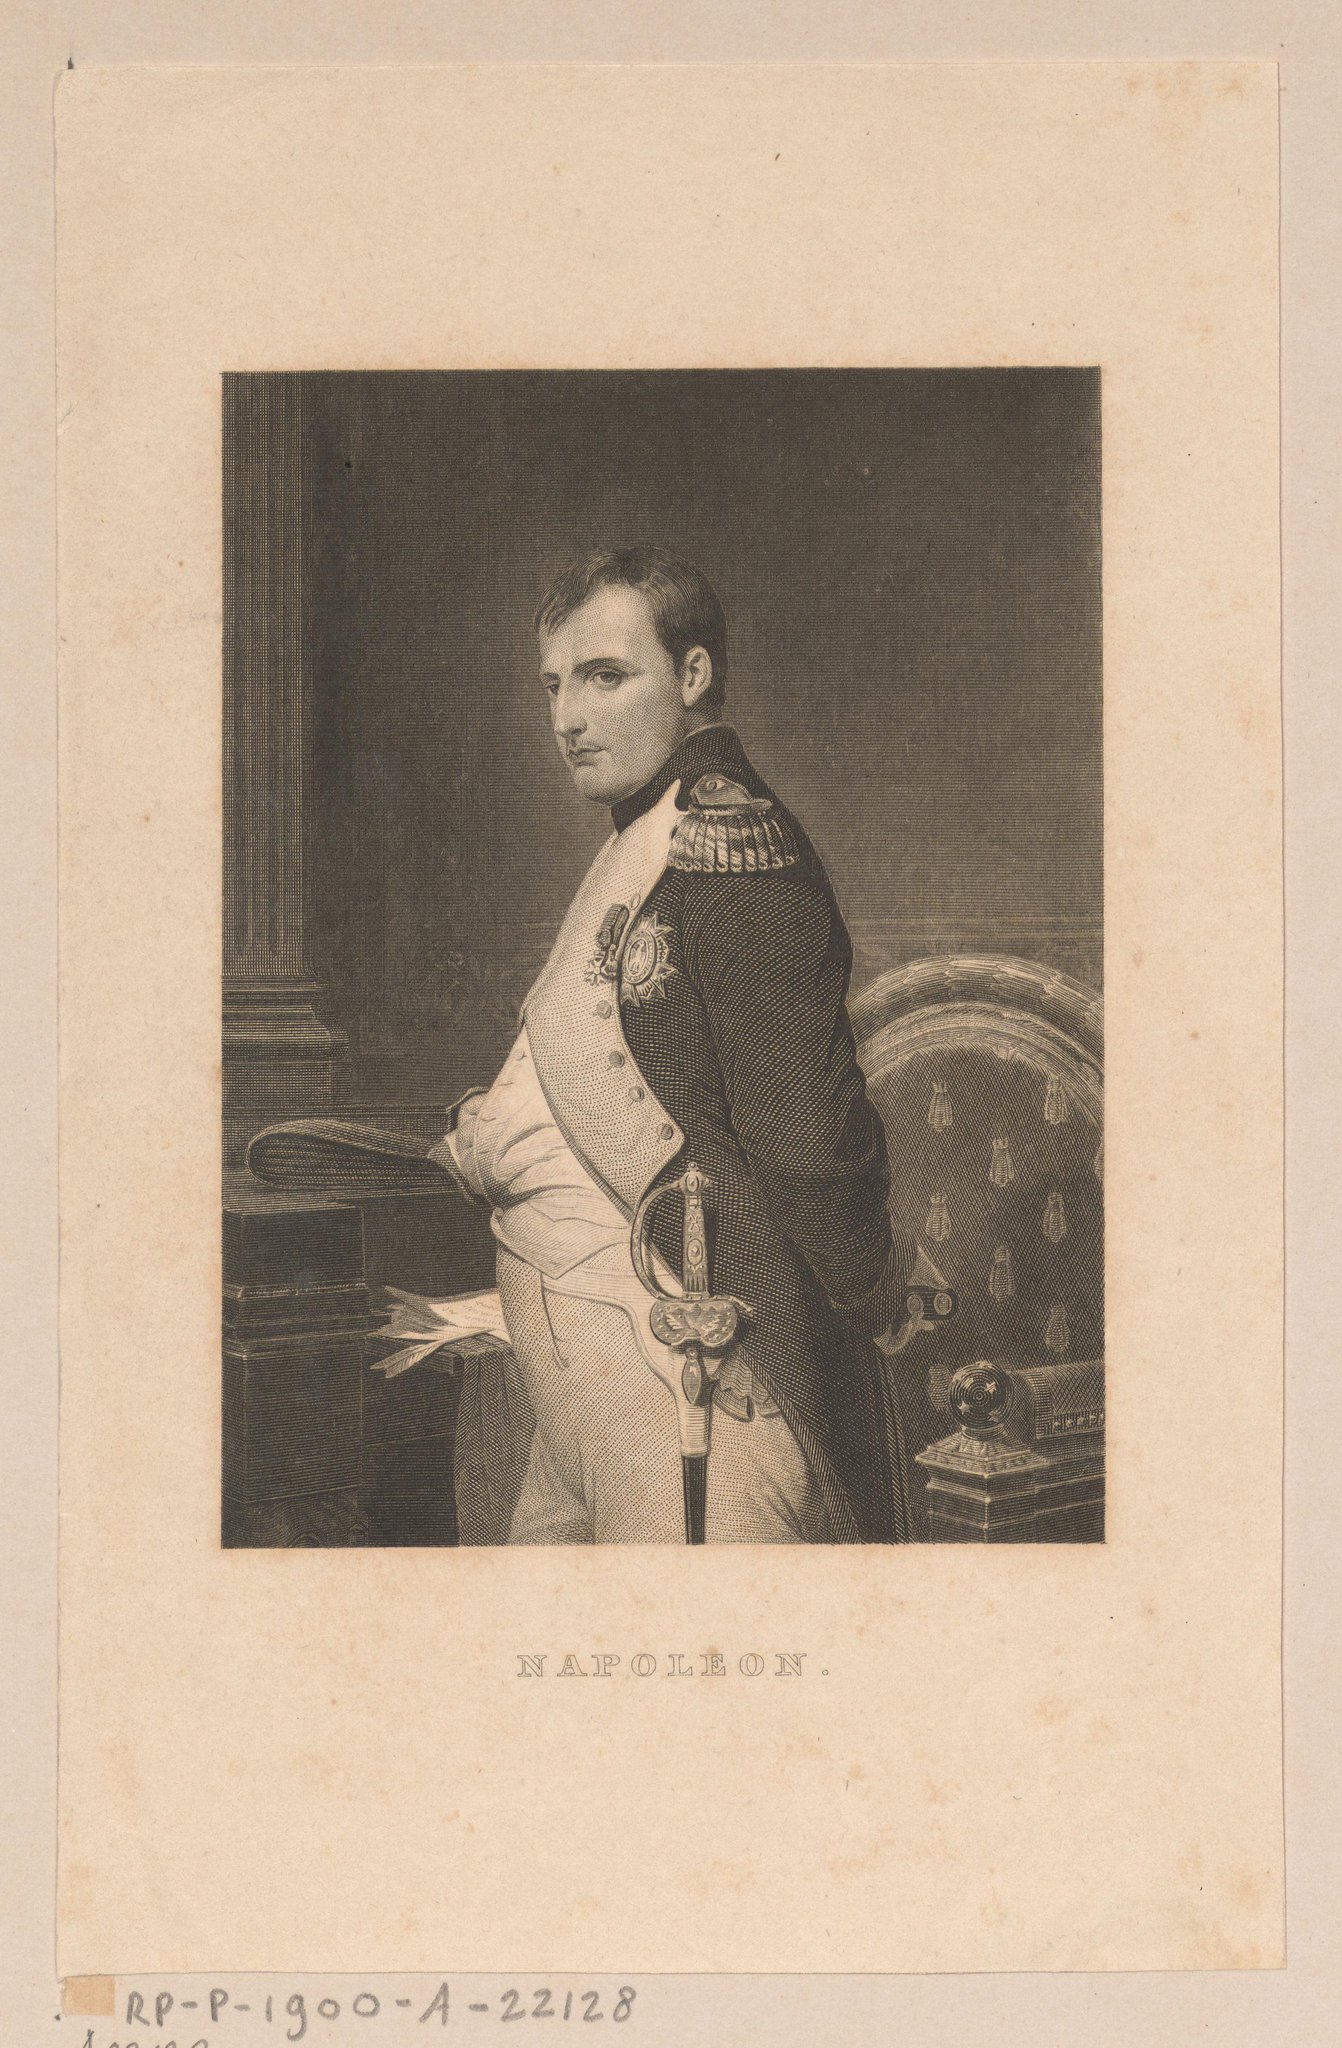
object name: print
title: Portret van Napoleon I Bonaparte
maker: Anonymous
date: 1804-1850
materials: paper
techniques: etching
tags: napoleon i (emperor of the french), historical persons, emperor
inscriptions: collector's mark: Lugt 2228